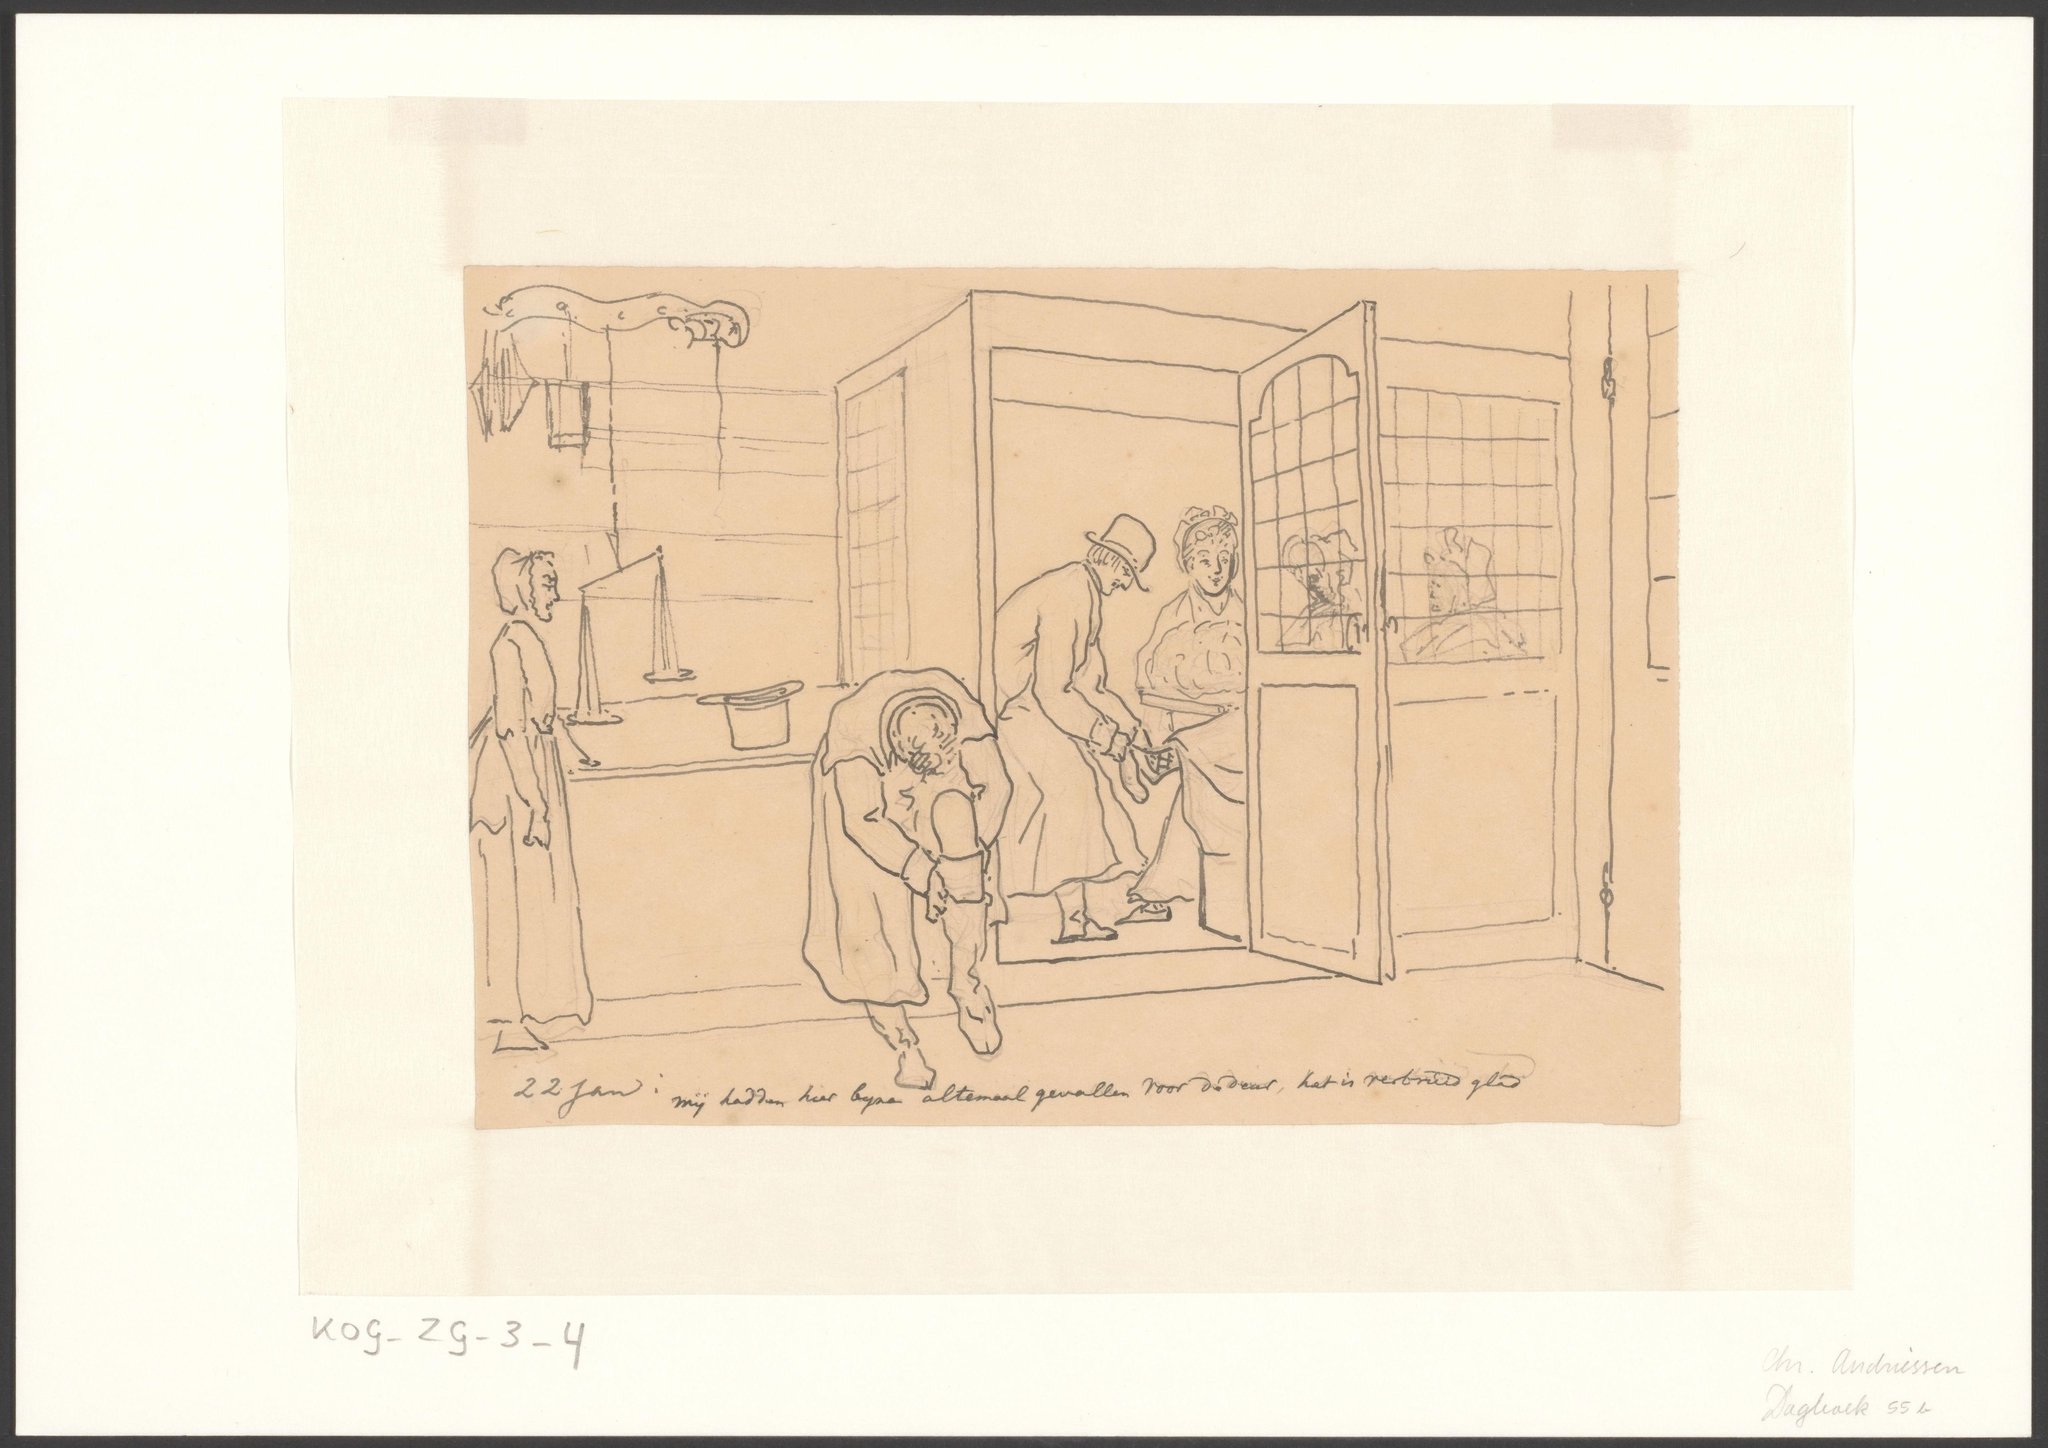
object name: drawing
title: Christiaan Andriessen en zijn familie komen binnen na een wandeling op gladde straten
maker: christiaan andriessen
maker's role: draughtsman, print maker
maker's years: 1775-1846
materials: ink, paper, pencil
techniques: pen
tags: ice ~ freezing weather, vestibule, hall, interior of the house, putting on or taking off stockings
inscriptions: inscription, inscription: ‘22 jan: wij hadden hier bijna allemaal gevallen voor de deur, het is verbruid glad’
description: Dagboekblad uit het getekende dagboek dat Christiaan Andriessen bijhield van 1805 tot en met 1808.